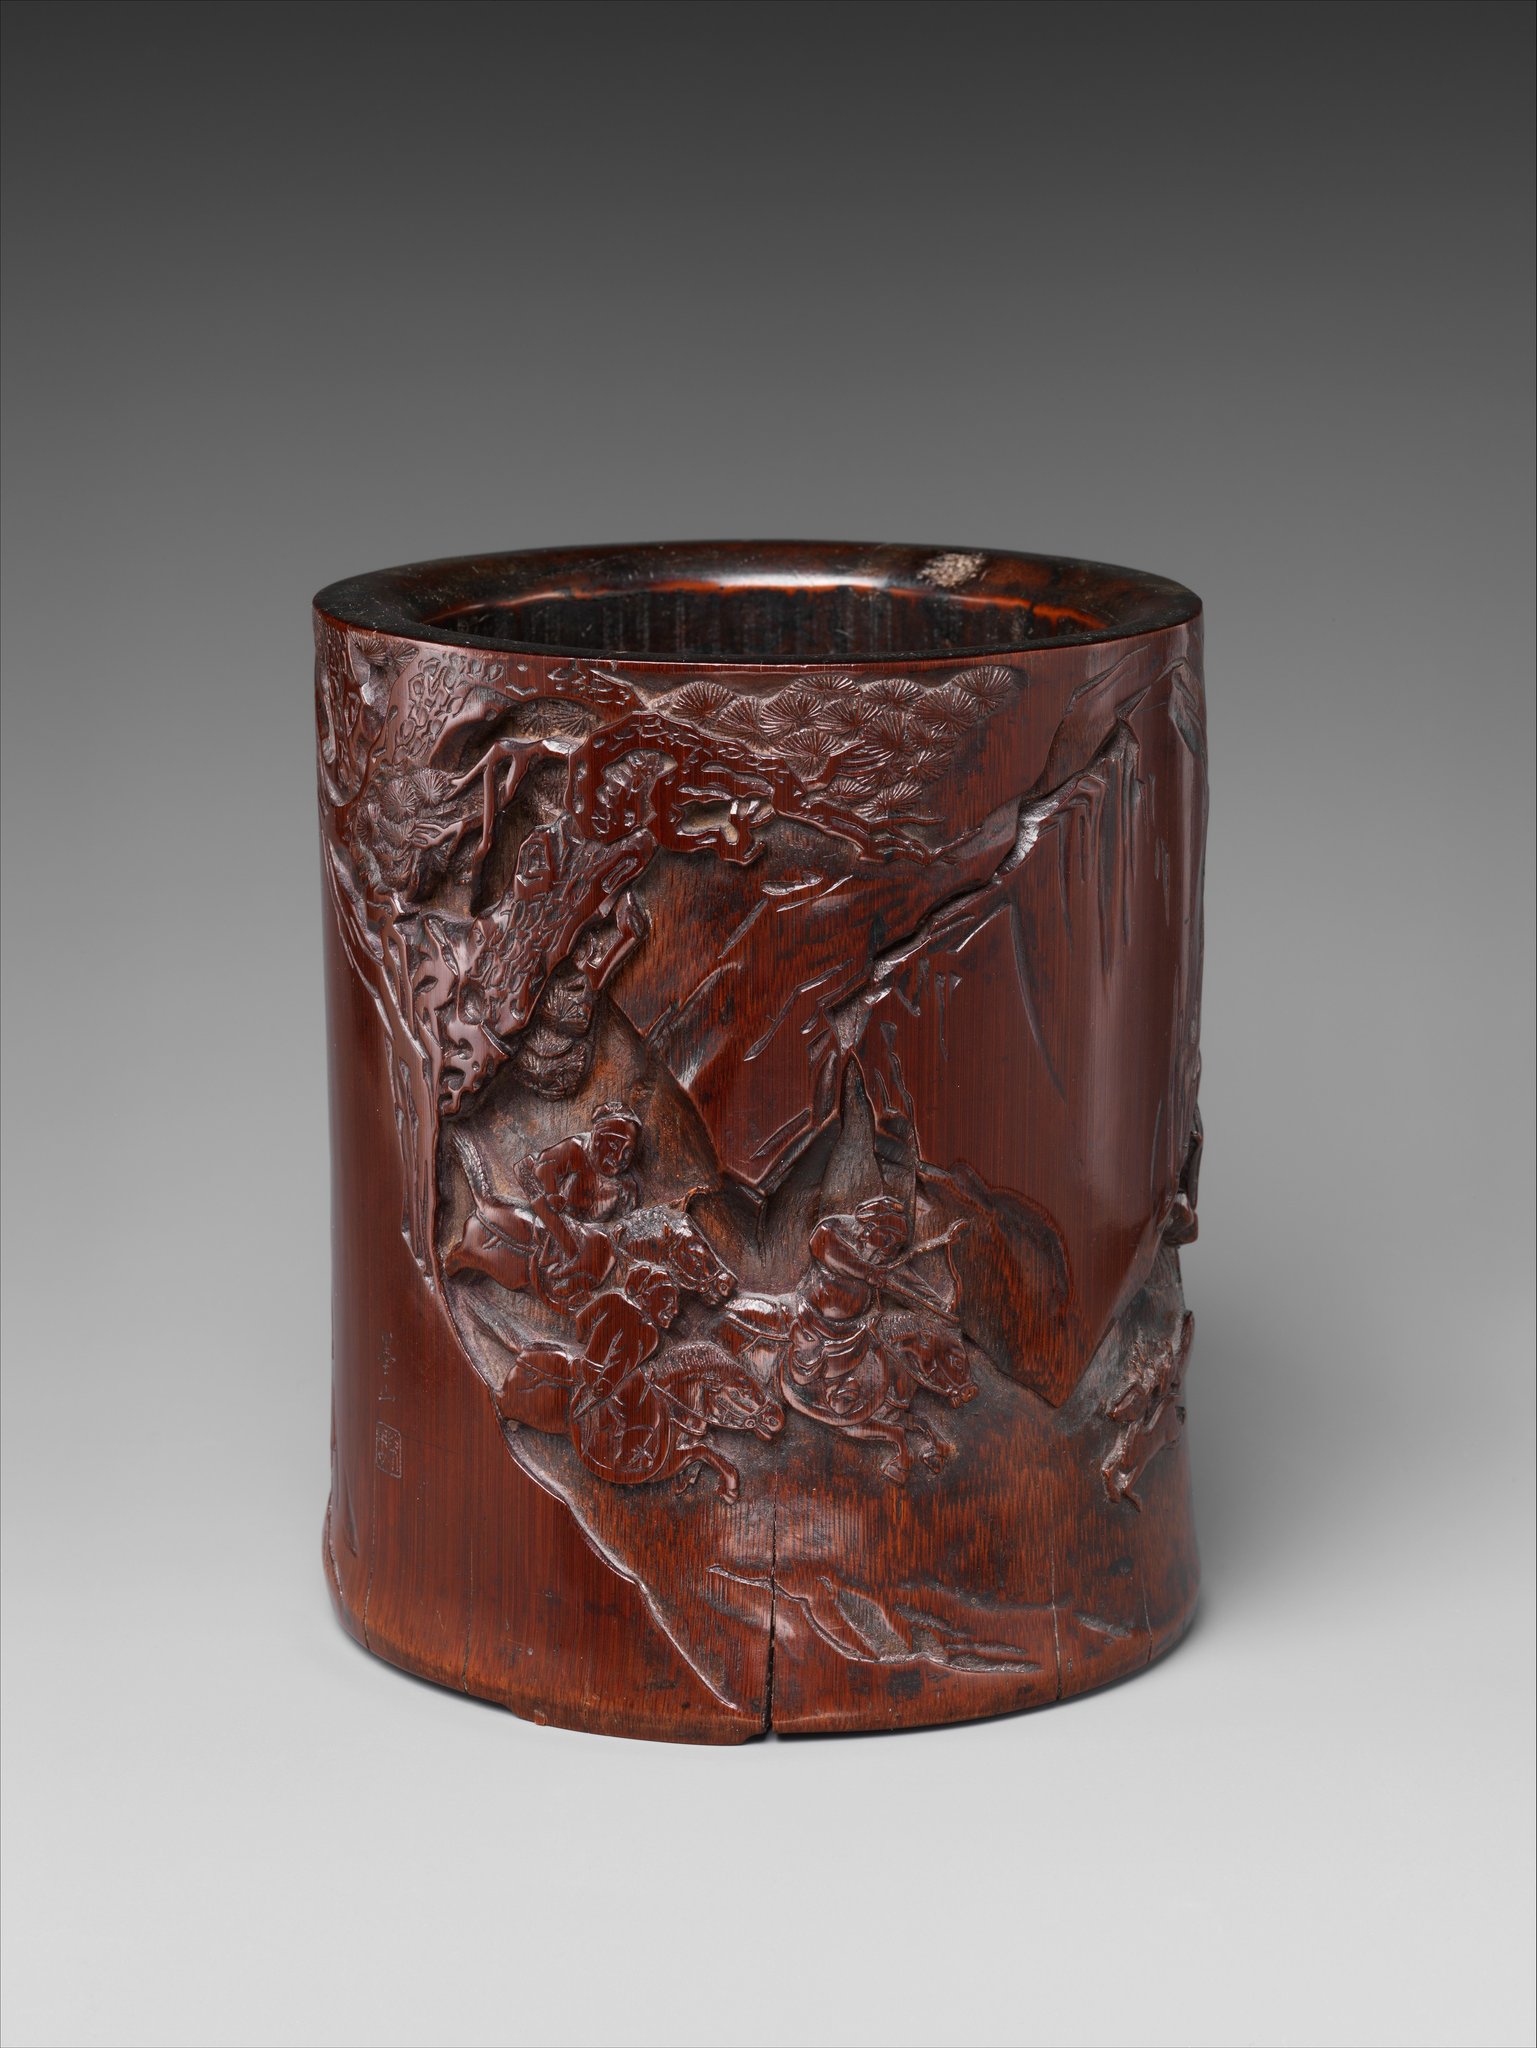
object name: brush pot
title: Brush pot with hunting scene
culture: chinese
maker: zhou naishi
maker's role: artist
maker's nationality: chinese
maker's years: 1644-1722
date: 1601-1700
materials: bamboo